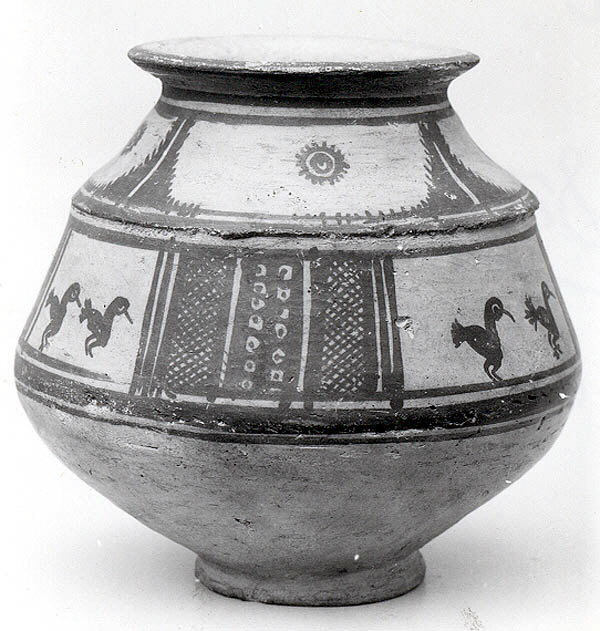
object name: jar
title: Jar with paired birds in panels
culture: iranian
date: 1600-1400 BCE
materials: ceramic, paint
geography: iran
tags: birds